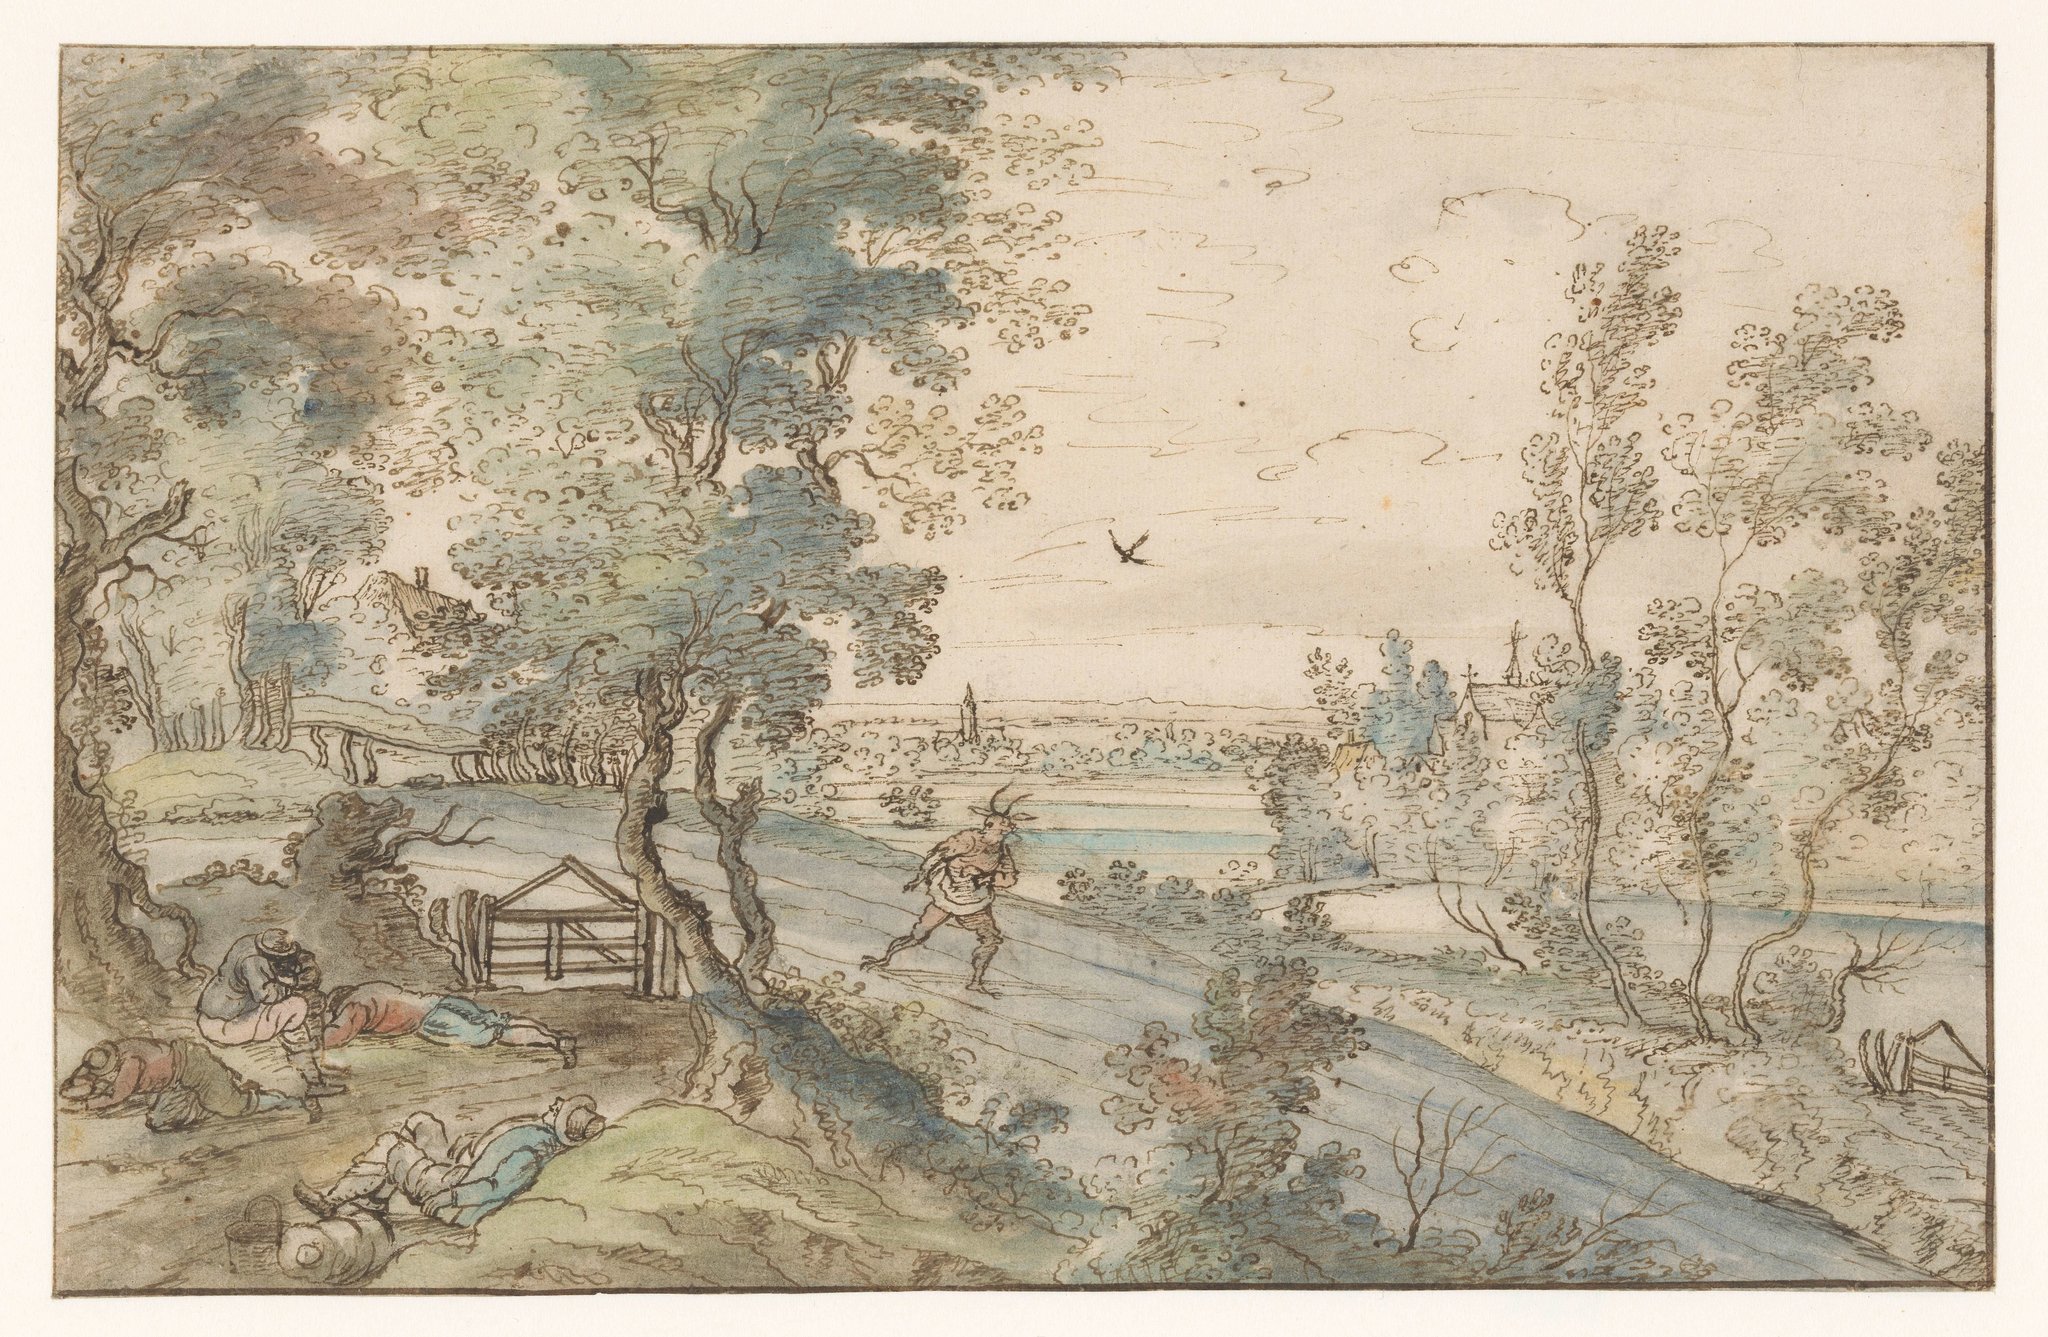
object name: drawing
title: De duivel zaait onkruid tussen het graan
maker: Anonymous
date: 1643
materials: paper, watercolor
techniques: brush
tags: while the sower and his servants slept, his enemy (the devil) sowed tares among the wheat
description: Terwijl de boeren slapen, zaait de duivel onkruid tussen het graan